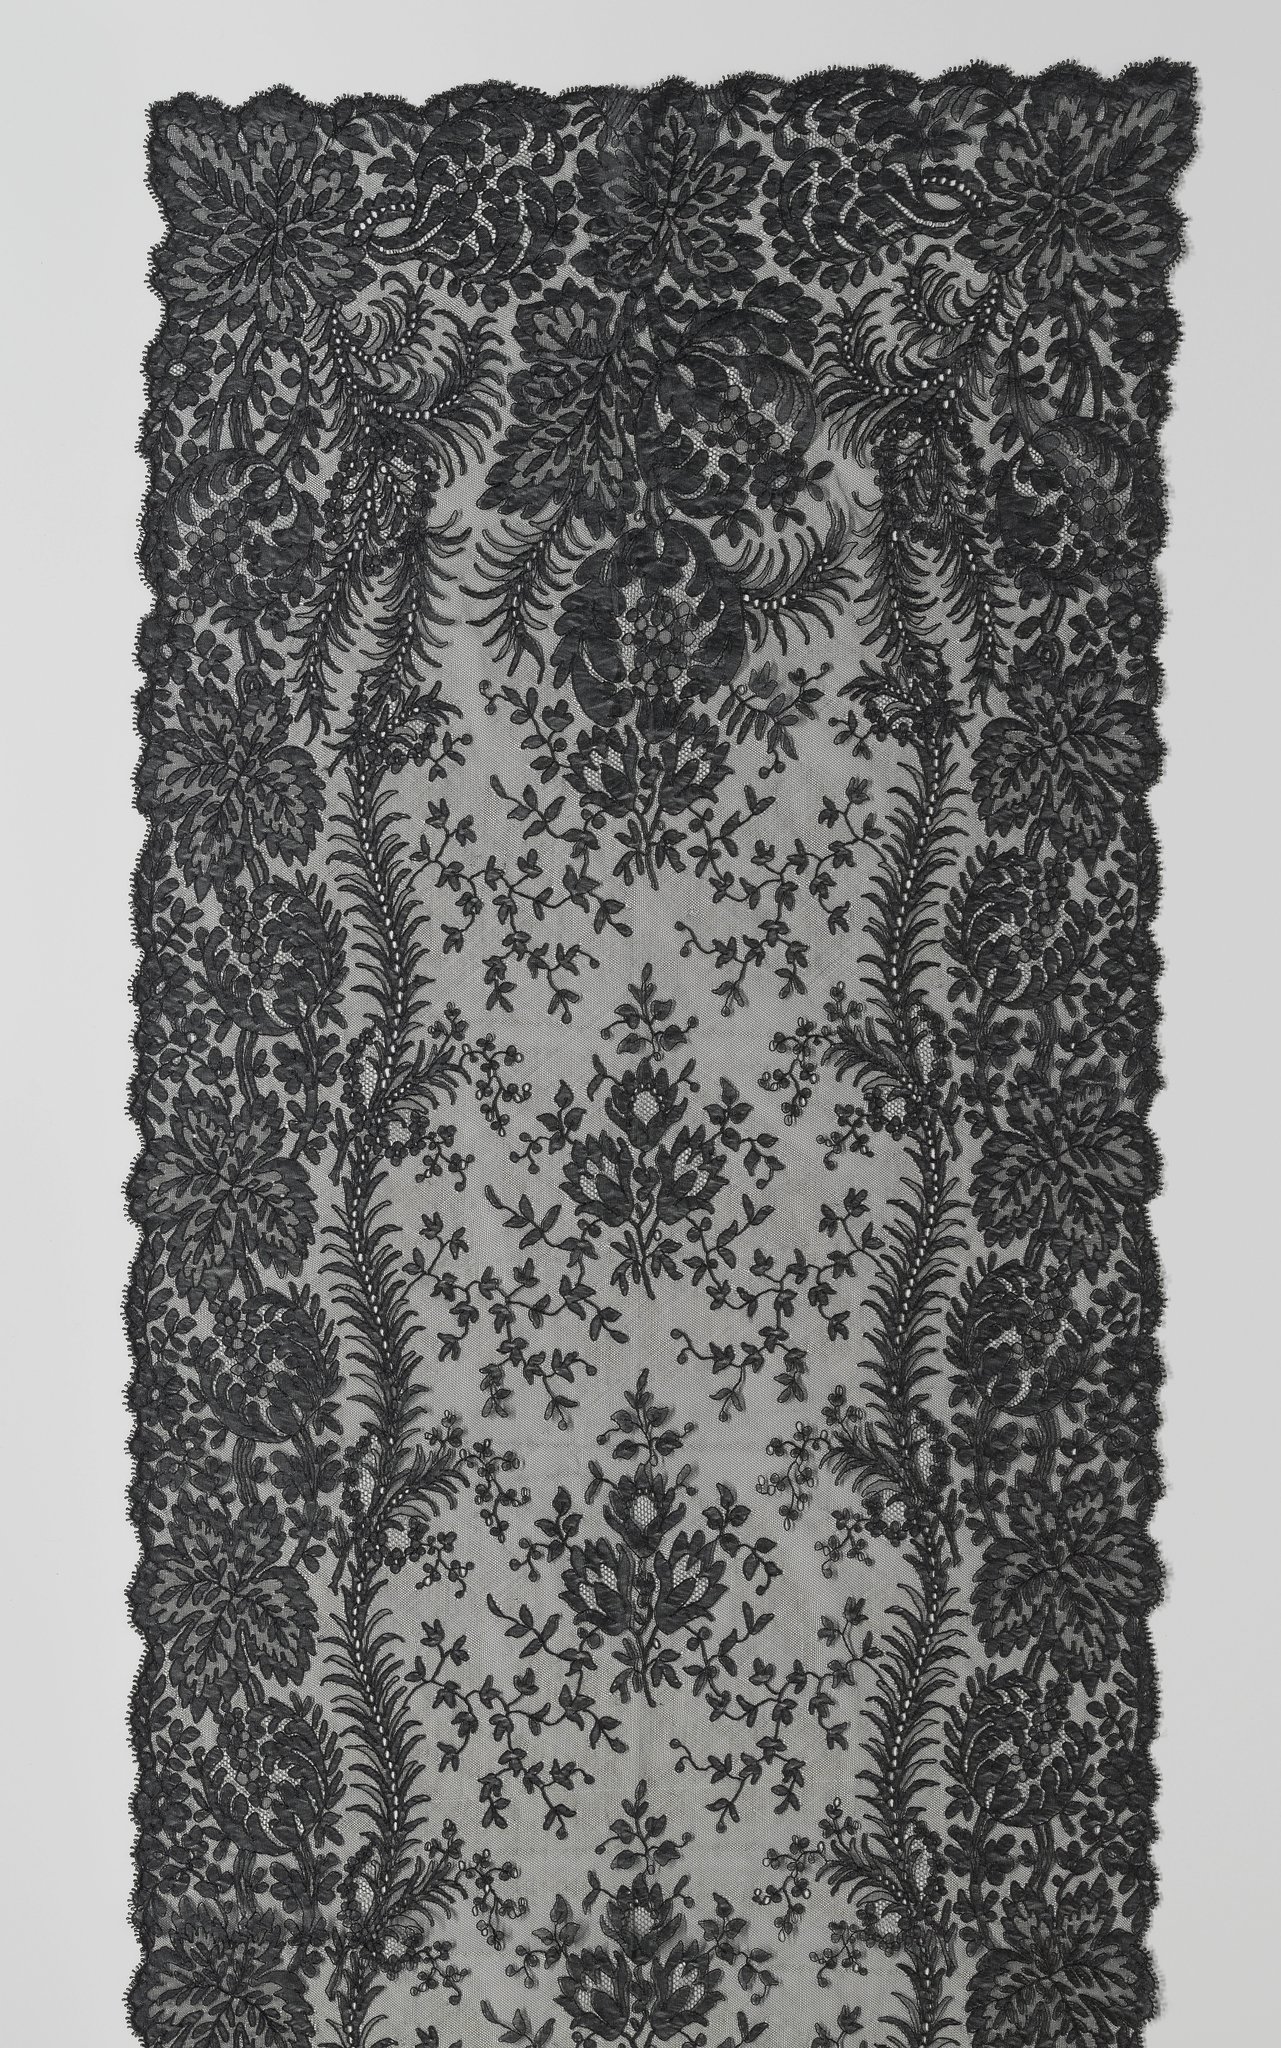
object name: womenswear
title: Langwerpige sjaal van zwarte zijden machinale kant met wijnbladeren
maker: Anonymous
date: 1900-1924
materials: silk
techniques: lace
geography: europe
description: Sjaal van zwarte machinale kant, imitatie van Chantilly-kant. De dikkere contourdraden zijn met de hand toegevoegd. Langwerpig rechthoekig model met in het middenveld een rechte lijn van een zich herhalende bloemtak. Aan de bloemtak zitten drie bloemen en uitwaaierende ranke bladtakjes, die het middenveld vullen. Het middenveld wordt omlijst door lange golvende en gevederde bladeren met daaromheen een rand met wijnbladeren afgewisseld met grote exotische bloemen. De schulpenrand komt voort uit het patroon met wijnbladeren.